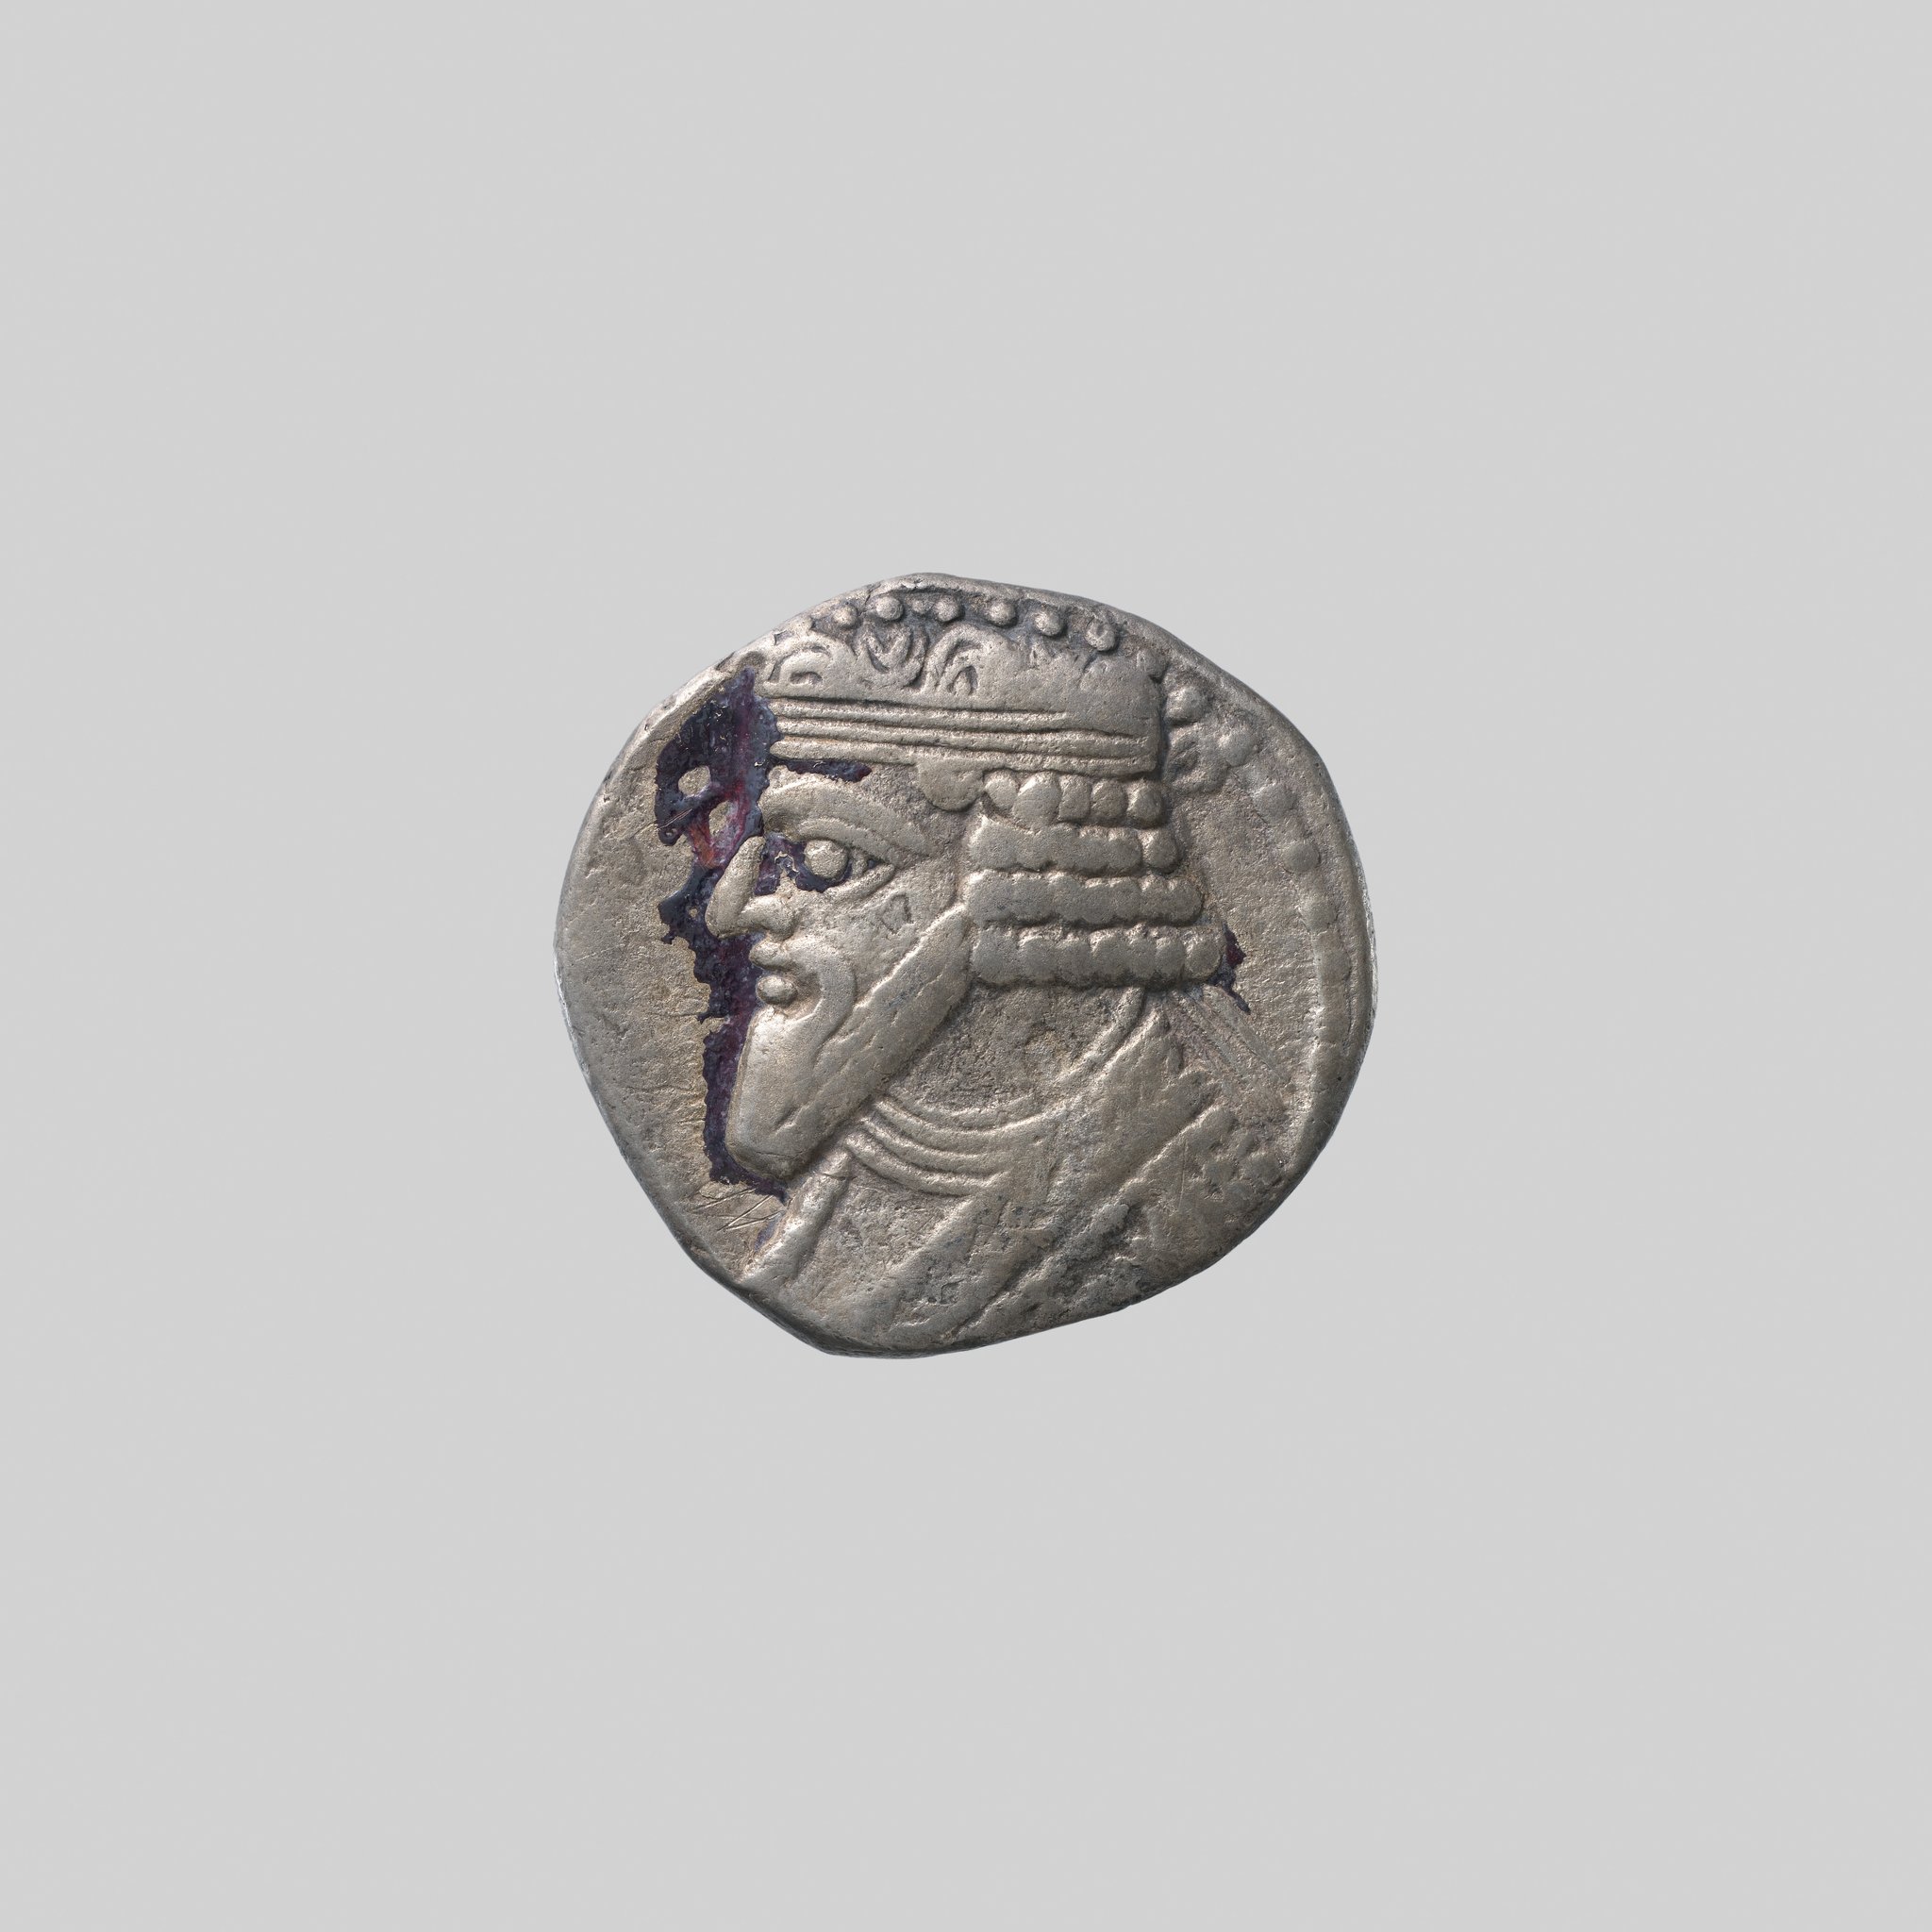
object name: coin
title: Tetradrachm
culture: parthian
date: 49-50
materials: silver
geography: iran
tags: men,profiles